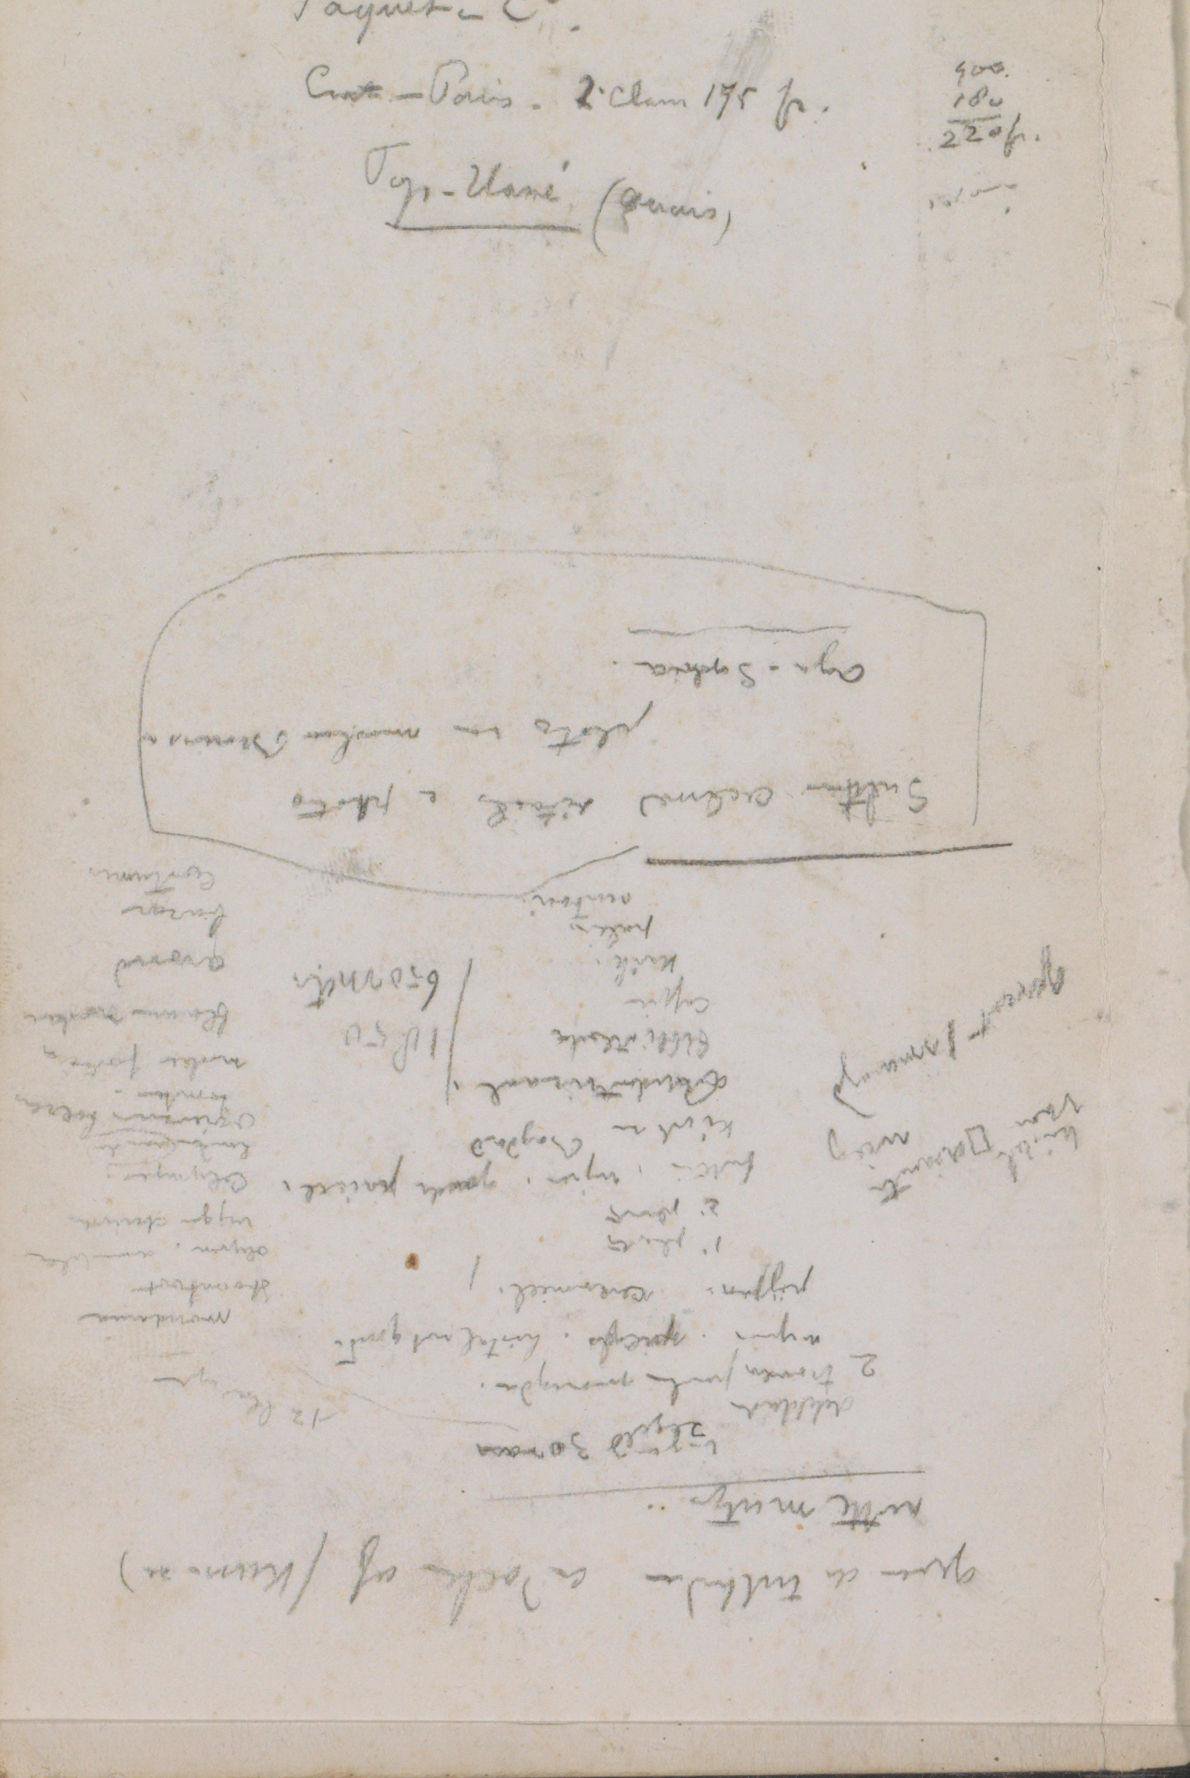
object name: endleaf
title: Blad met notities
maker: marius bauer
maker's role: draughtsman, print maker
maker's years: 1867-1932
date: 1896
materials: chalk, paper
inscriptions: collector's mark: Lugt 2228, annotation: ‘Paquet en Co/ [...] Paris [...]/ Sultan Achmed [...] & photo/ photo van moskee [...]/ Aya Sophia. [...]’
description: Voorste schutblad uit een schetsboek met 53 bladen.